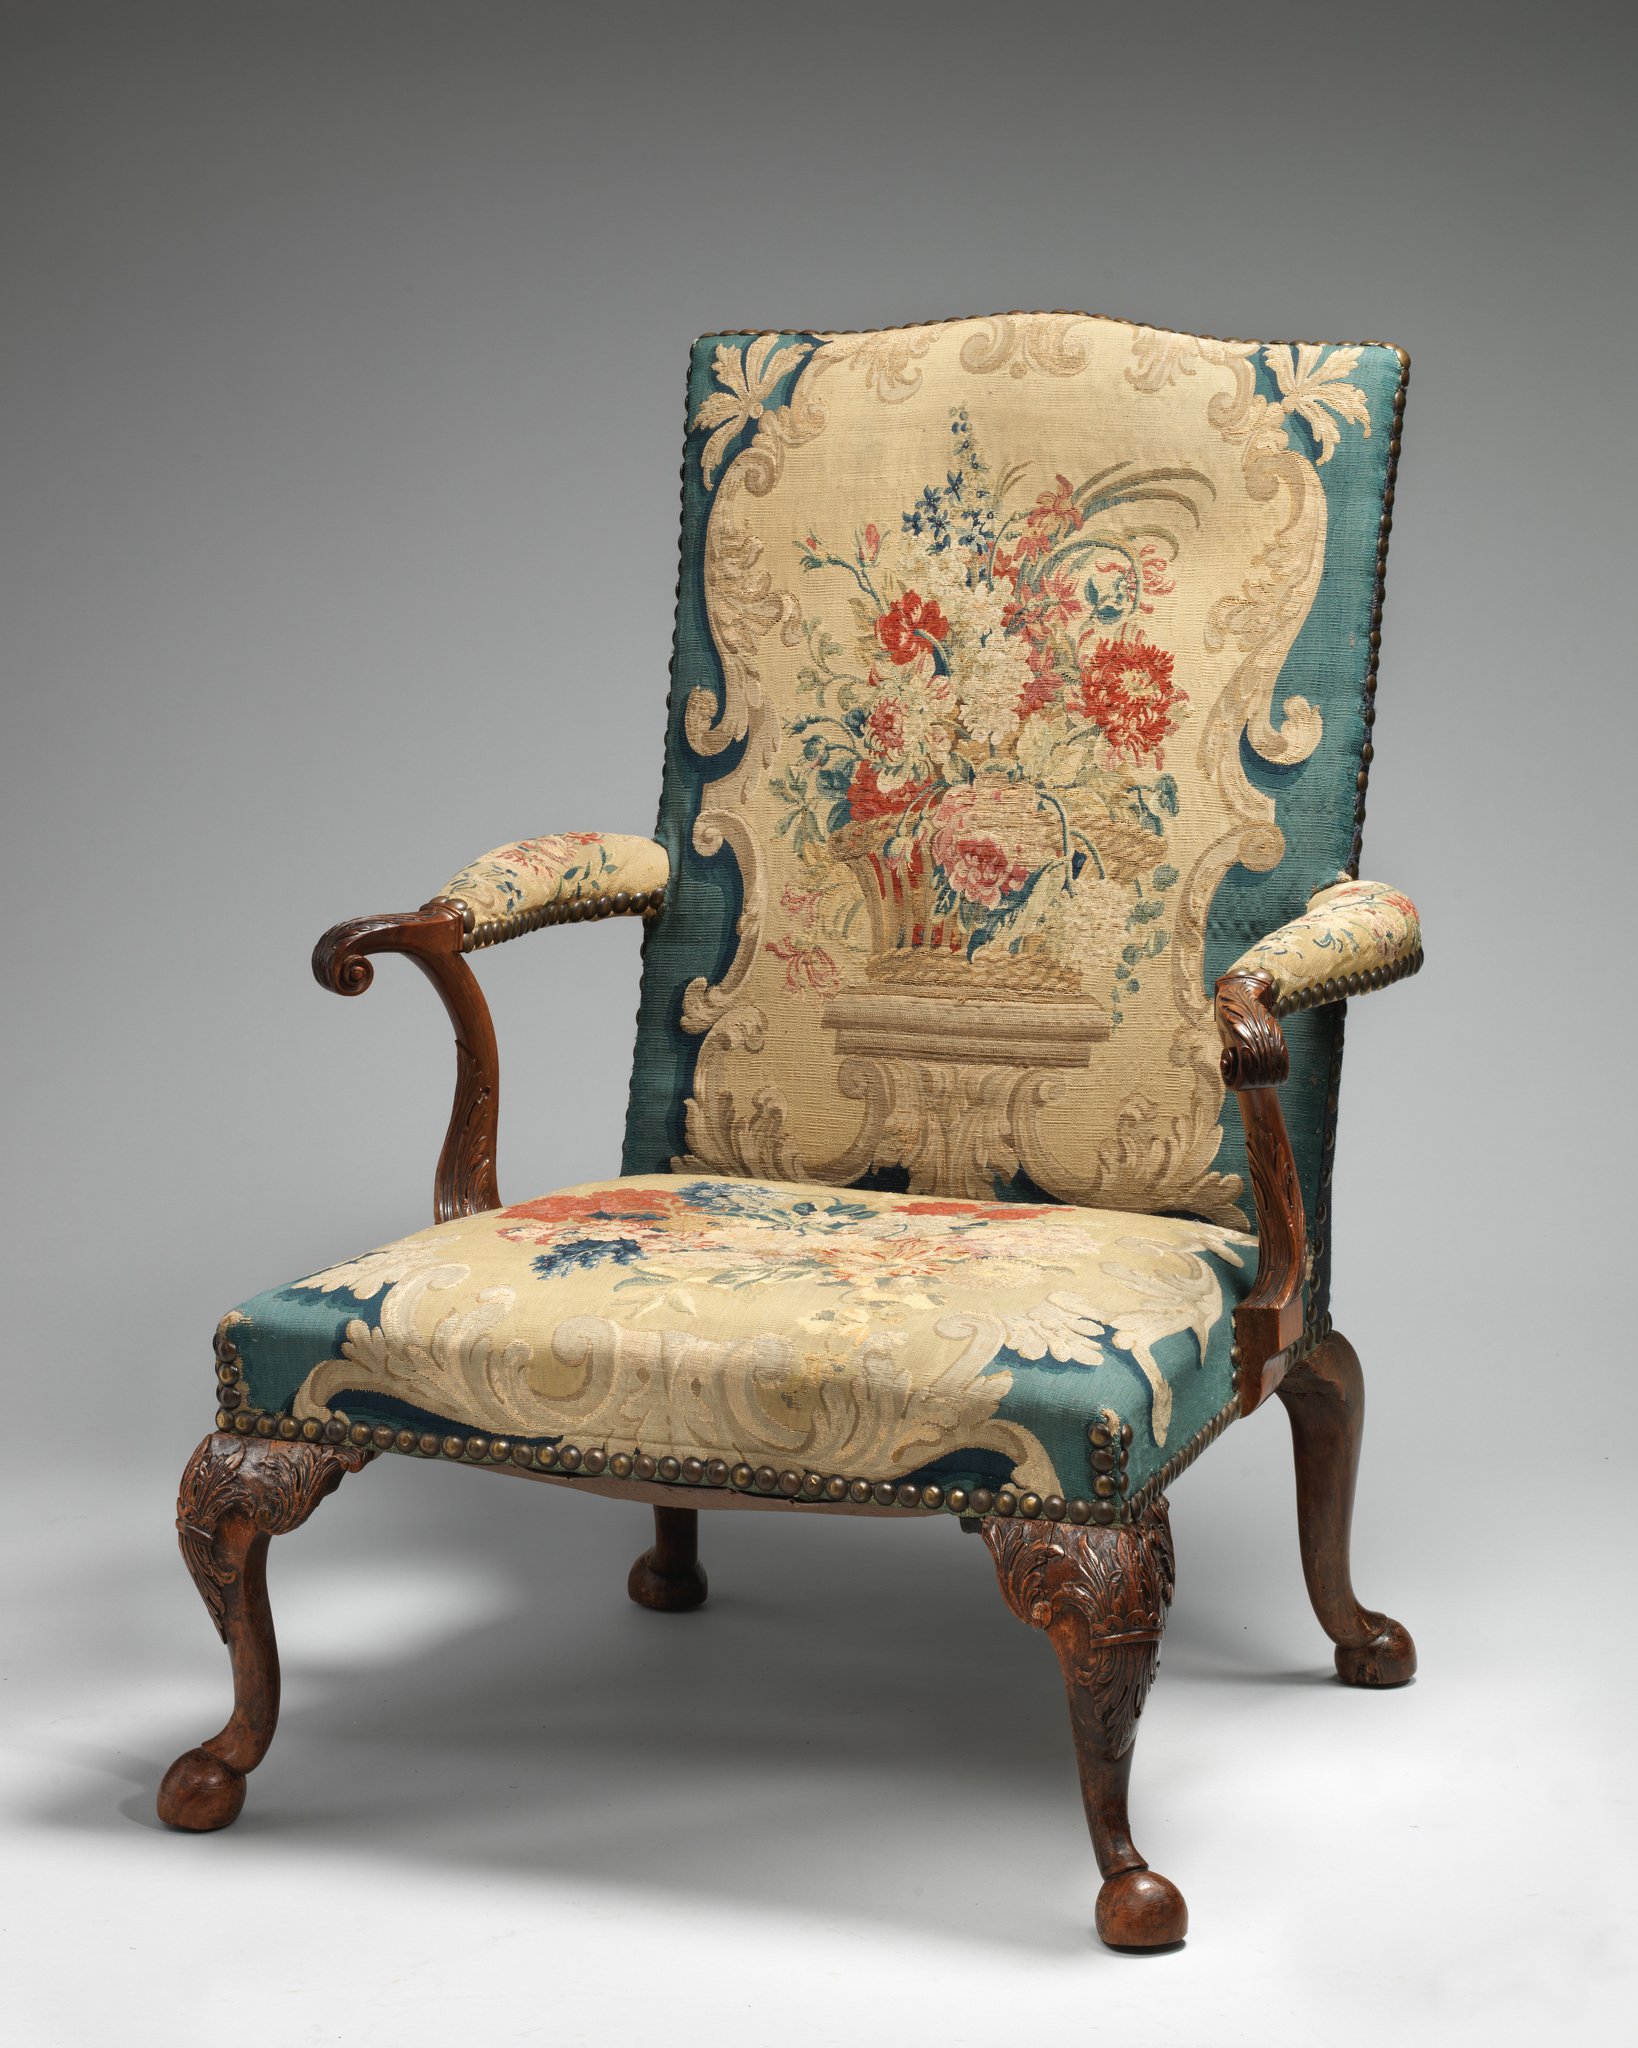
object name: armchair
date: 1740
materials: wood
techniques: tapestry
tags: flowers